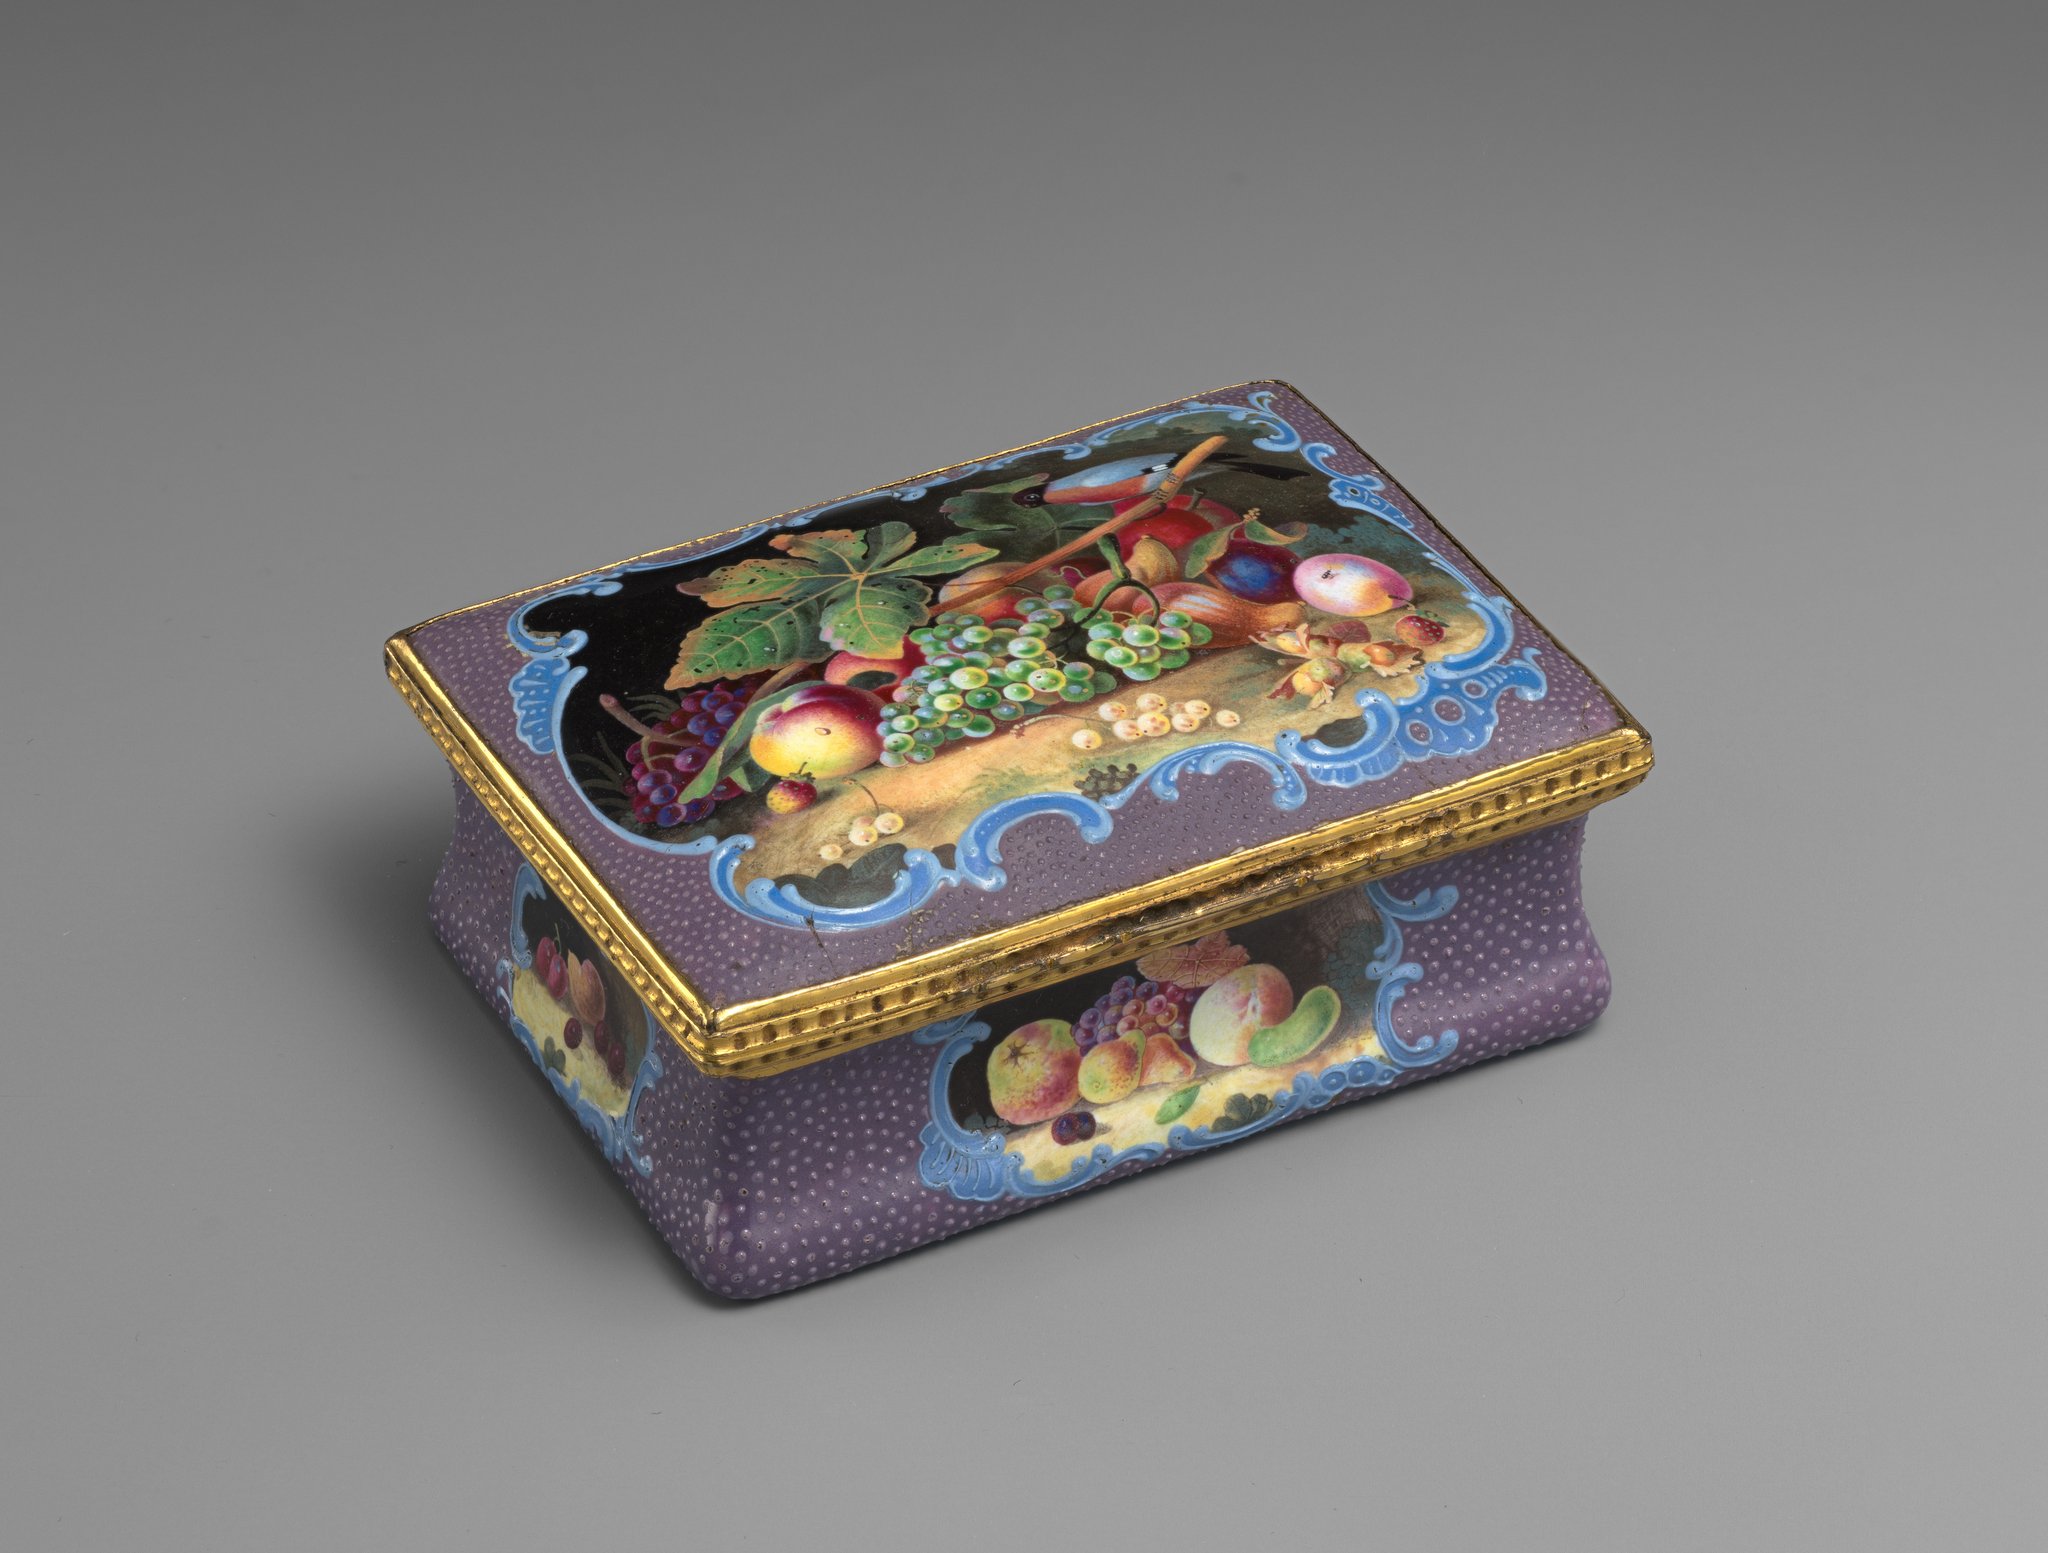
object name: snuffbox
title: Snuffbox with still life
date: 1765-1770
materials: copper, enamel